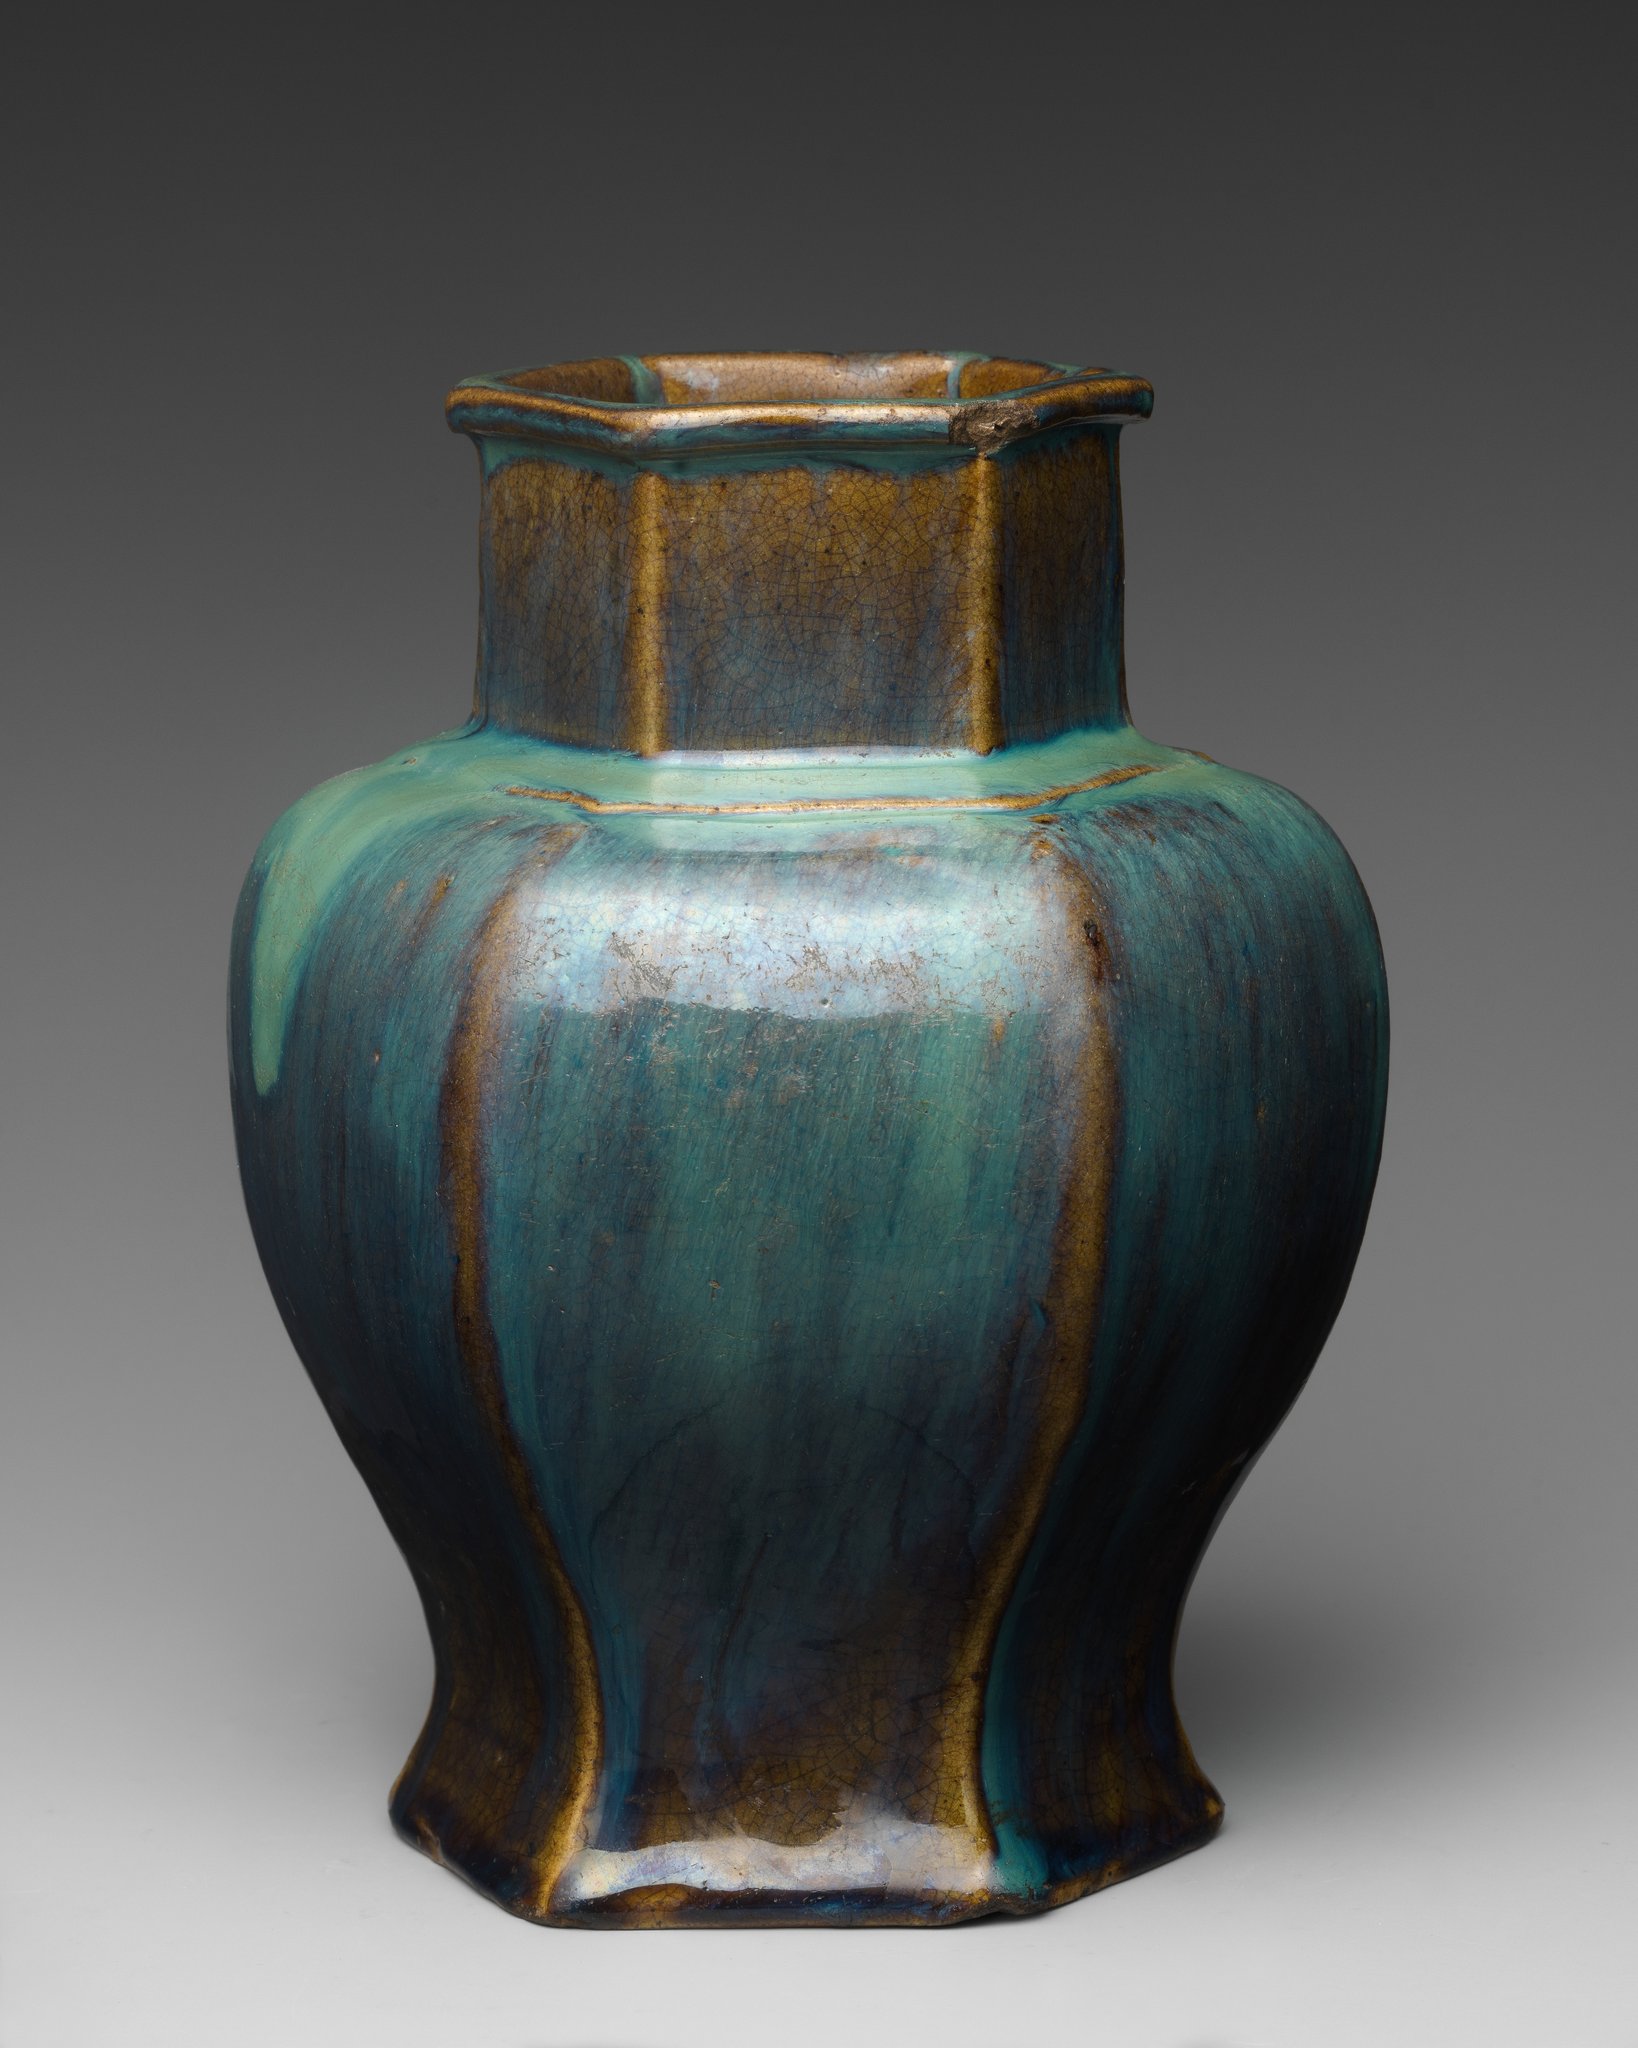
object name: vase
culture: japanese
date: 1801-1833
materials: clay, glaze